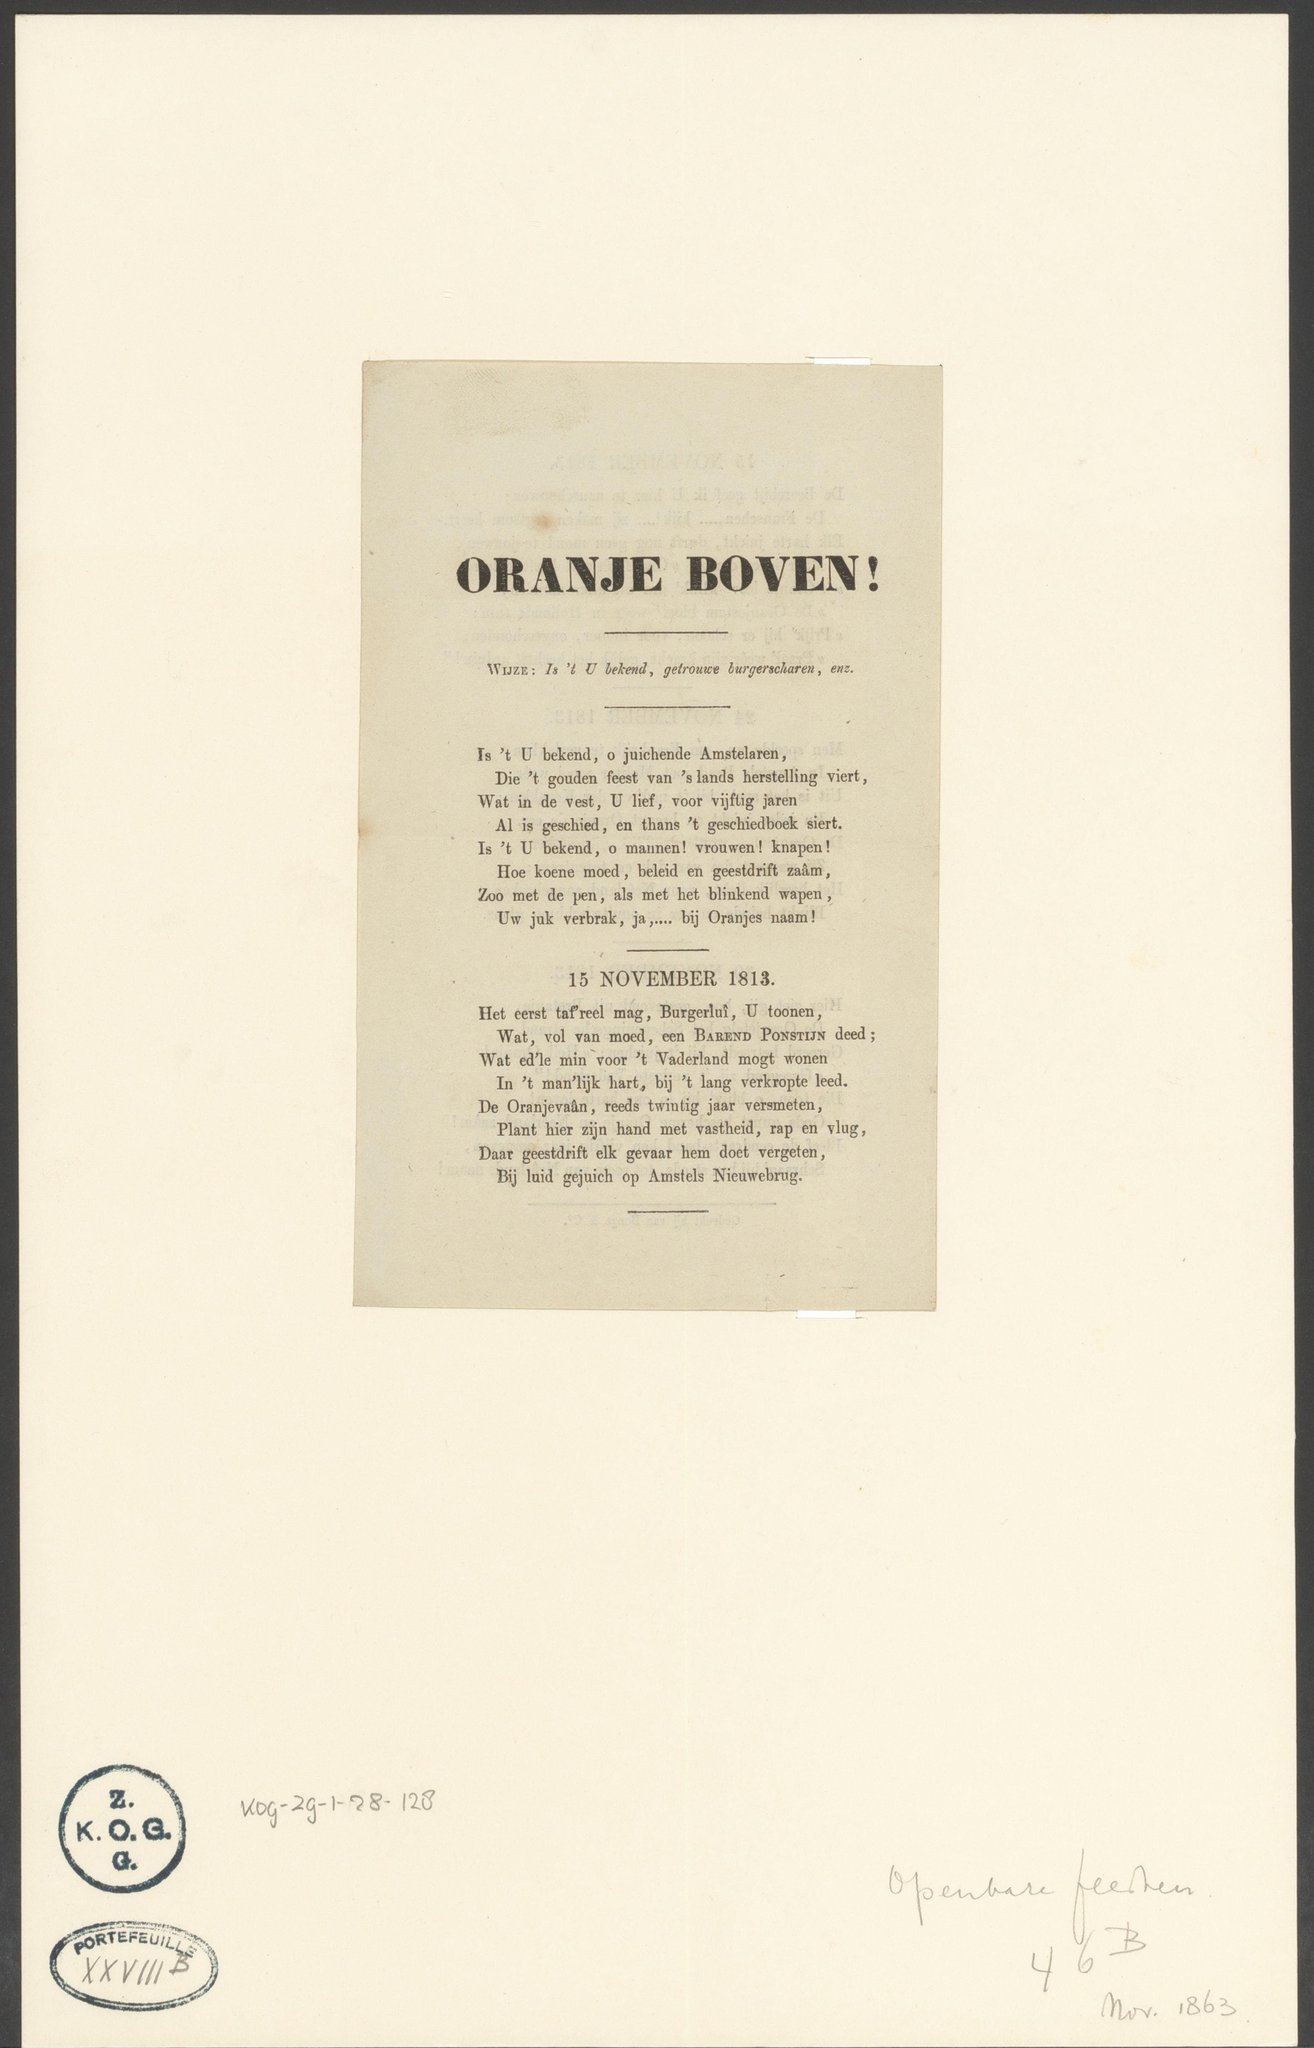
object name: text sheet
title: Liedtekst voor Oranje Boven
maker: pieter adriaan van overeem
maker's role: deurwaarder, dichter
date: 1813-1815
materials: paper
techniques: letterpress printing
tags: vocal popular music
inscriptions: collector's mark: Lugt 1641, stamp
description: Onderwerpsrubrieken binnen de Atlas Zeden en Gewoonten: Zeden en Gewoonten in Engeren Zin. Volksleven. Openbare feesten. Vorstelijke intochten, (Illuminaties, vuurwerken en dergelijke, openbare feesten).